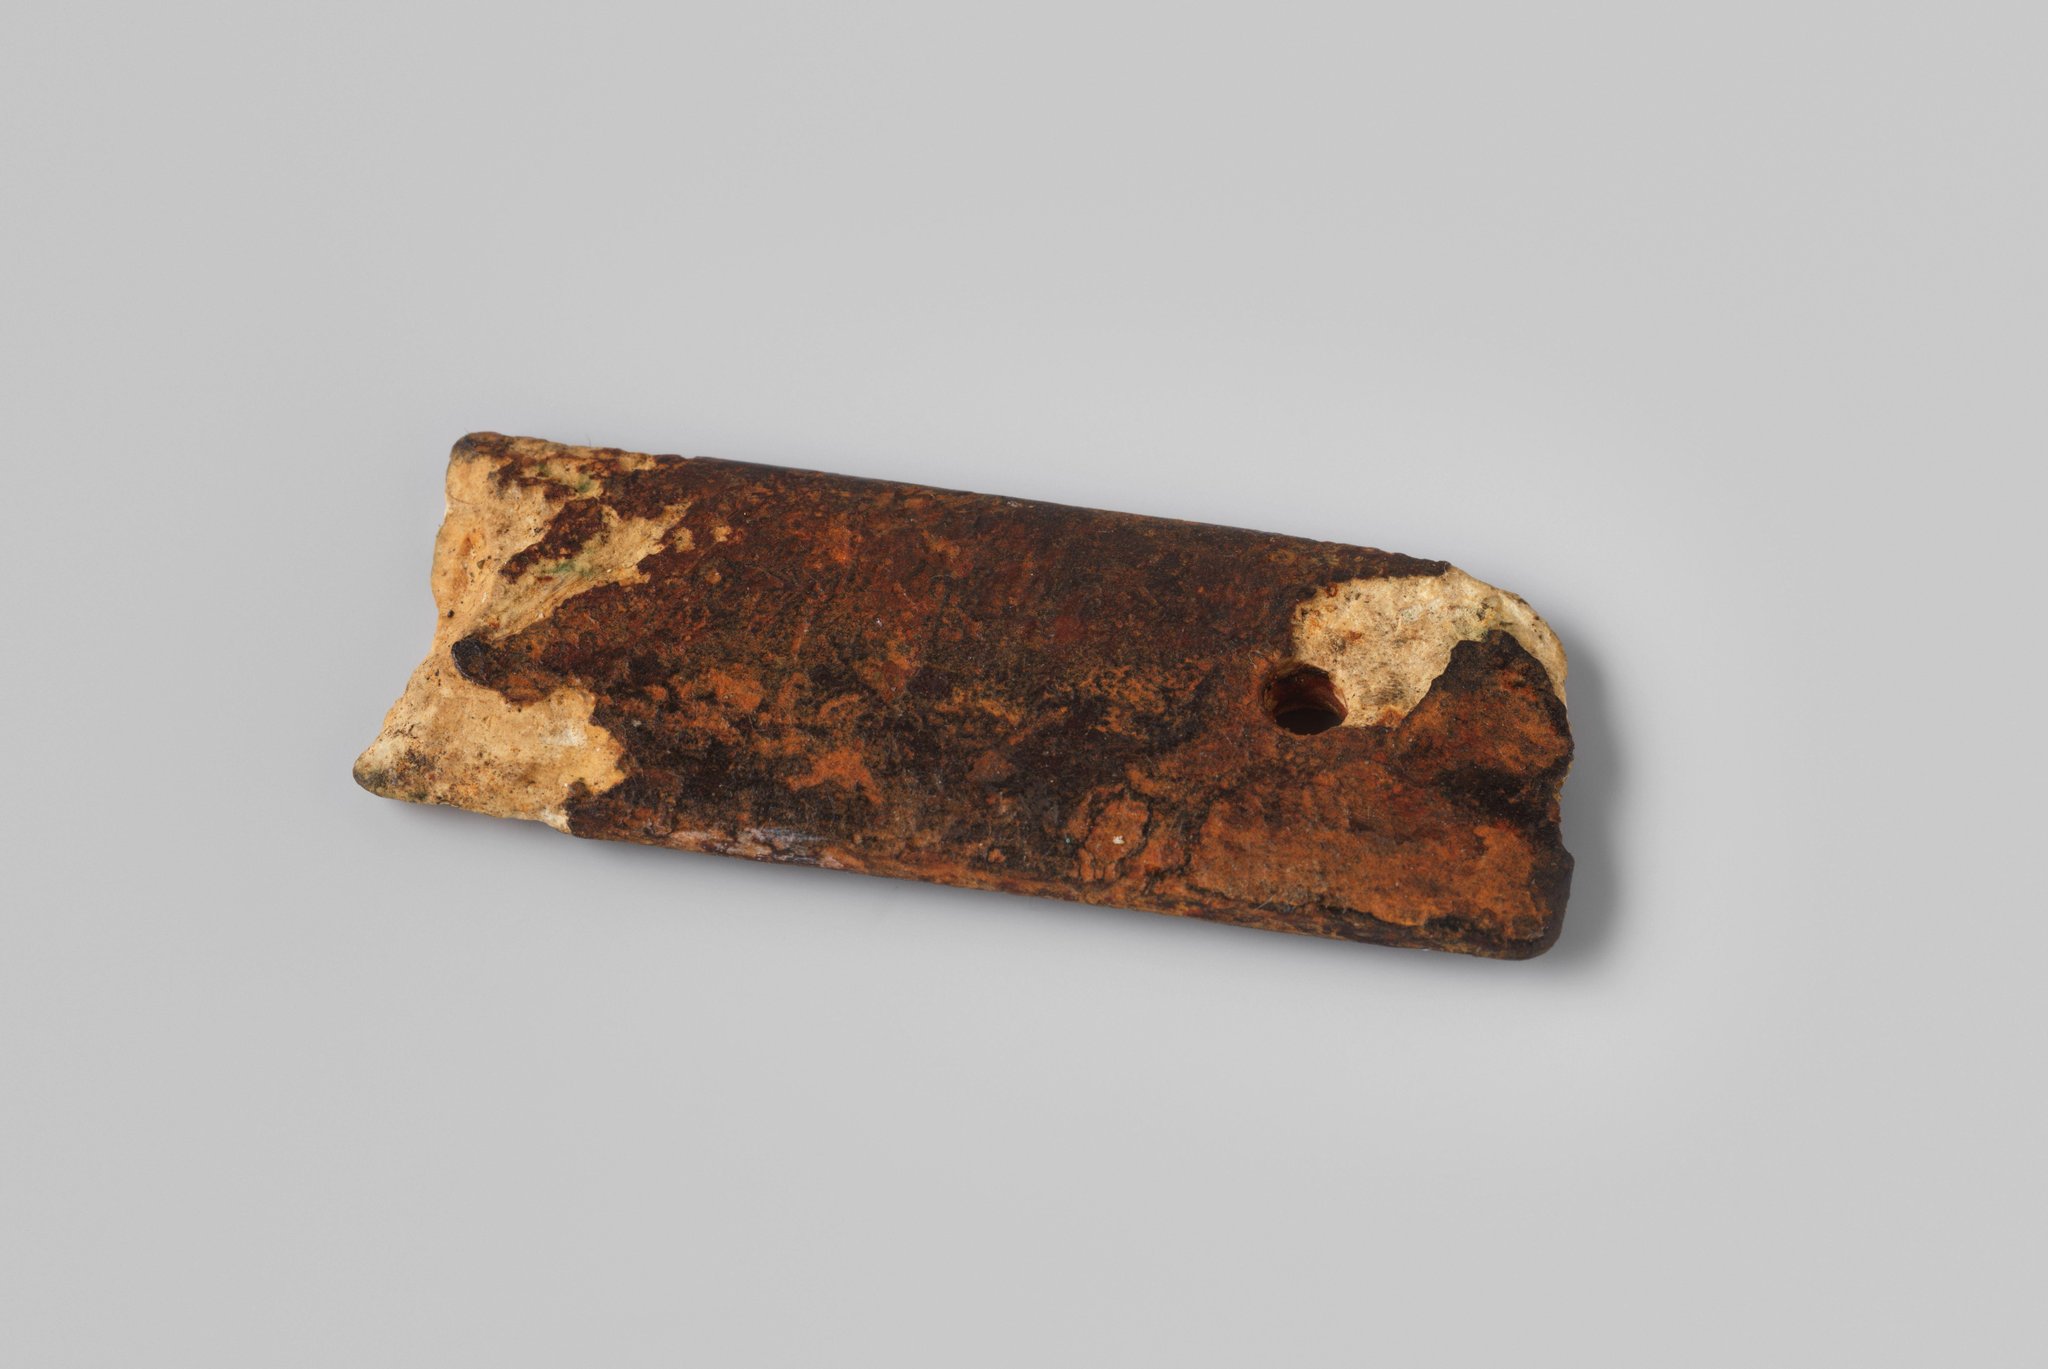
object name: knife tool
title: Papiermes uit het wrak van de Oost-Indiëvaarder Hollandia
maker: Anonymous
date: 1700-1743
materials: bone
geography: netherlands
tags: verenigde oostindische compagnie, hollandia (schip), annet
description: Knife, fragm, broken, id. NG 1980-27H660.